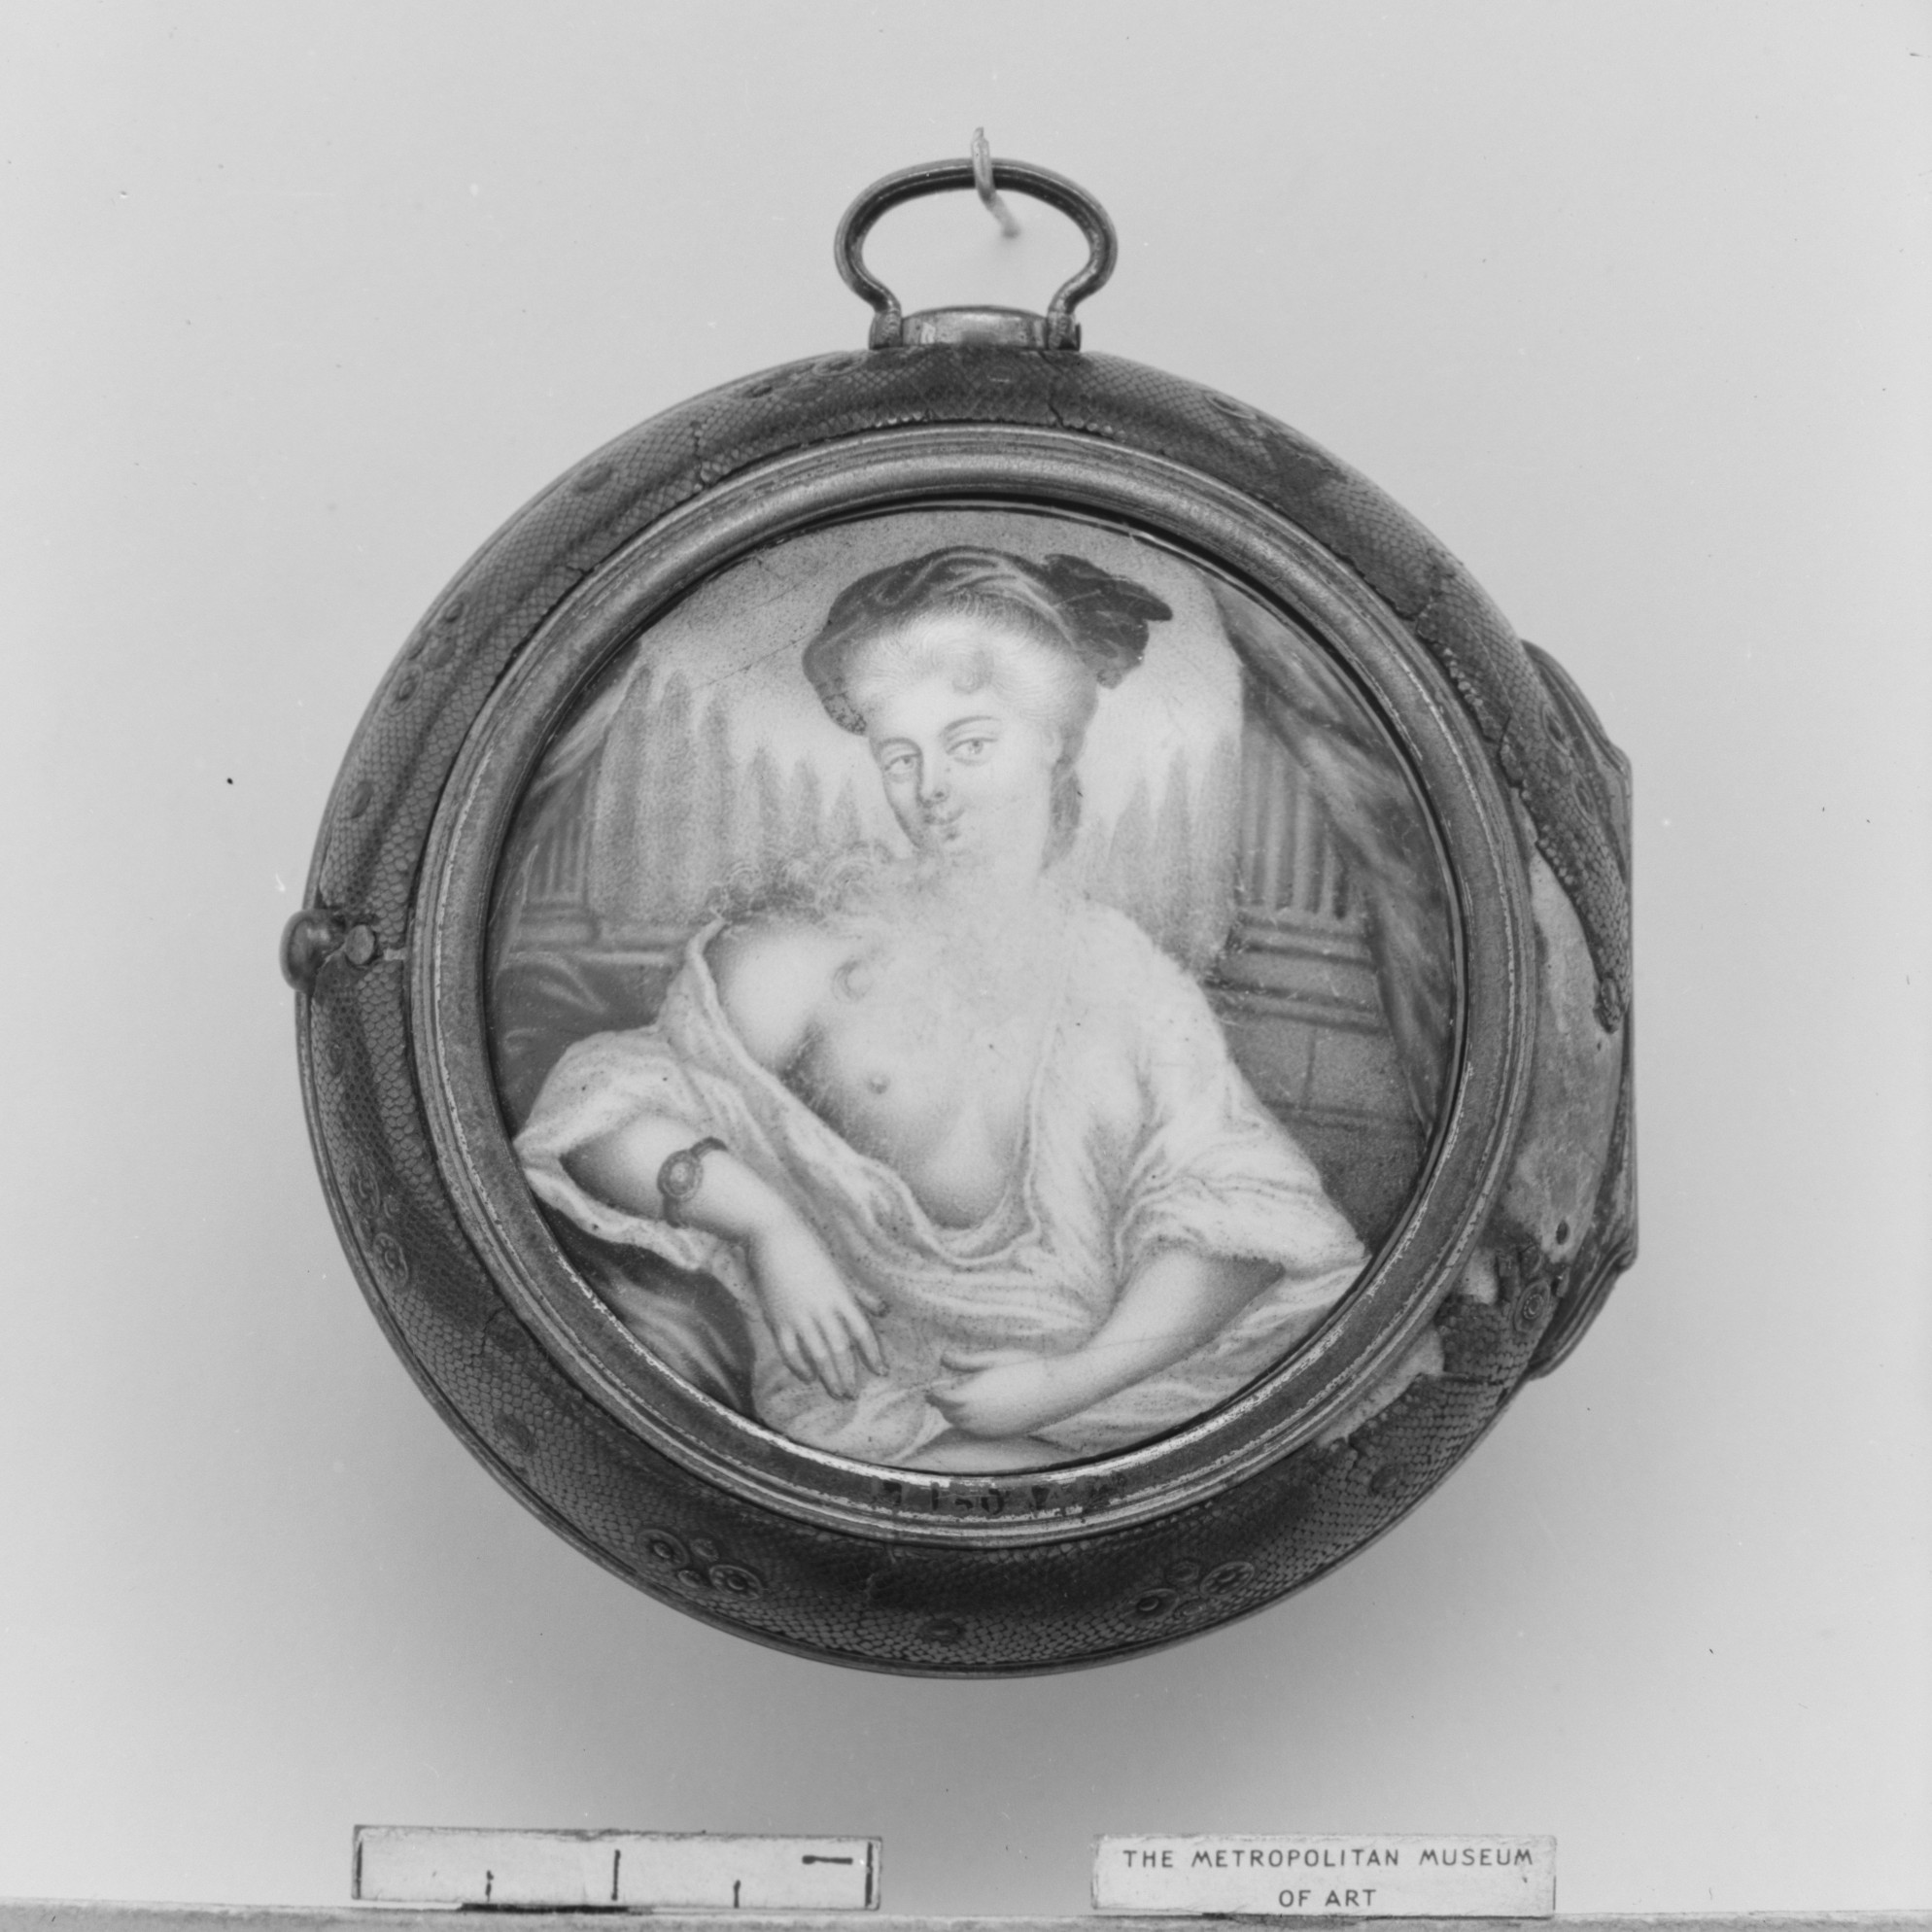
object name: watch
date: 1720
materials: enamel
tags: portraits,women